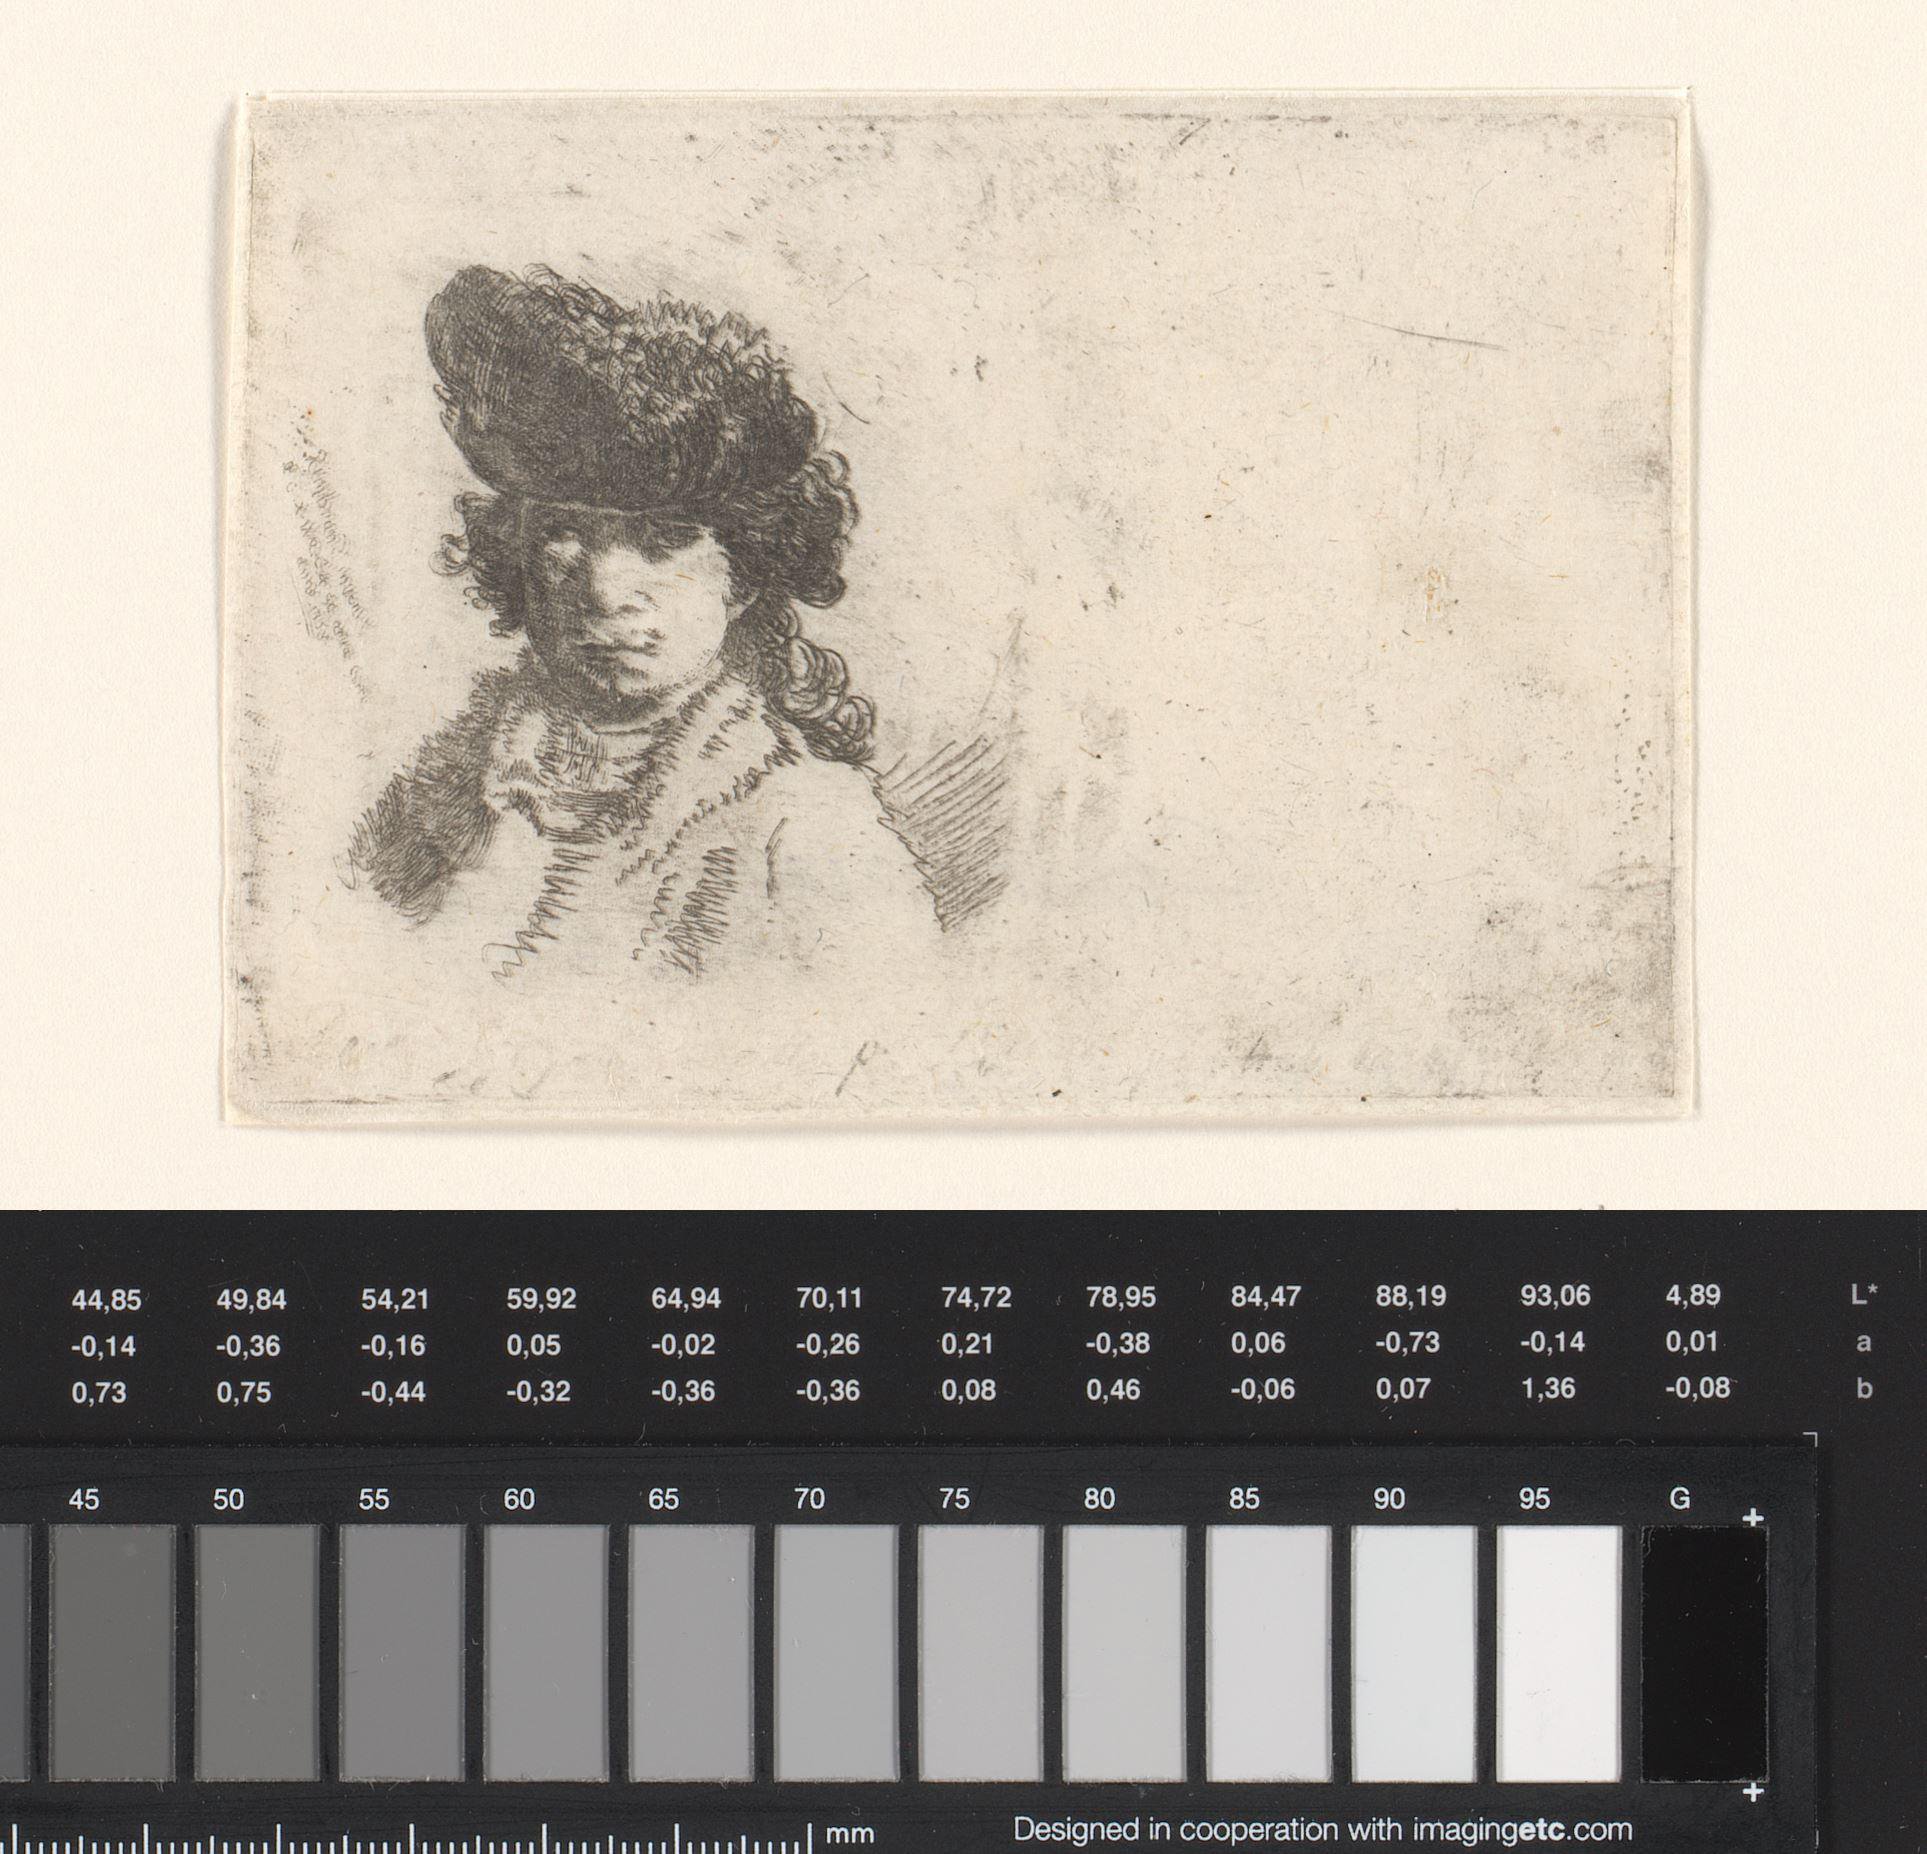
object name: print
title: Self-portrait in a fur cap: bust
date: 1758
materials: paper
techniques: etching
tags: leiden, amsterdam, painter, print maker, draughtsman, rembrandt van rijn, historical persons, portrait, self-portrait of graphic artist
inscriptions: date